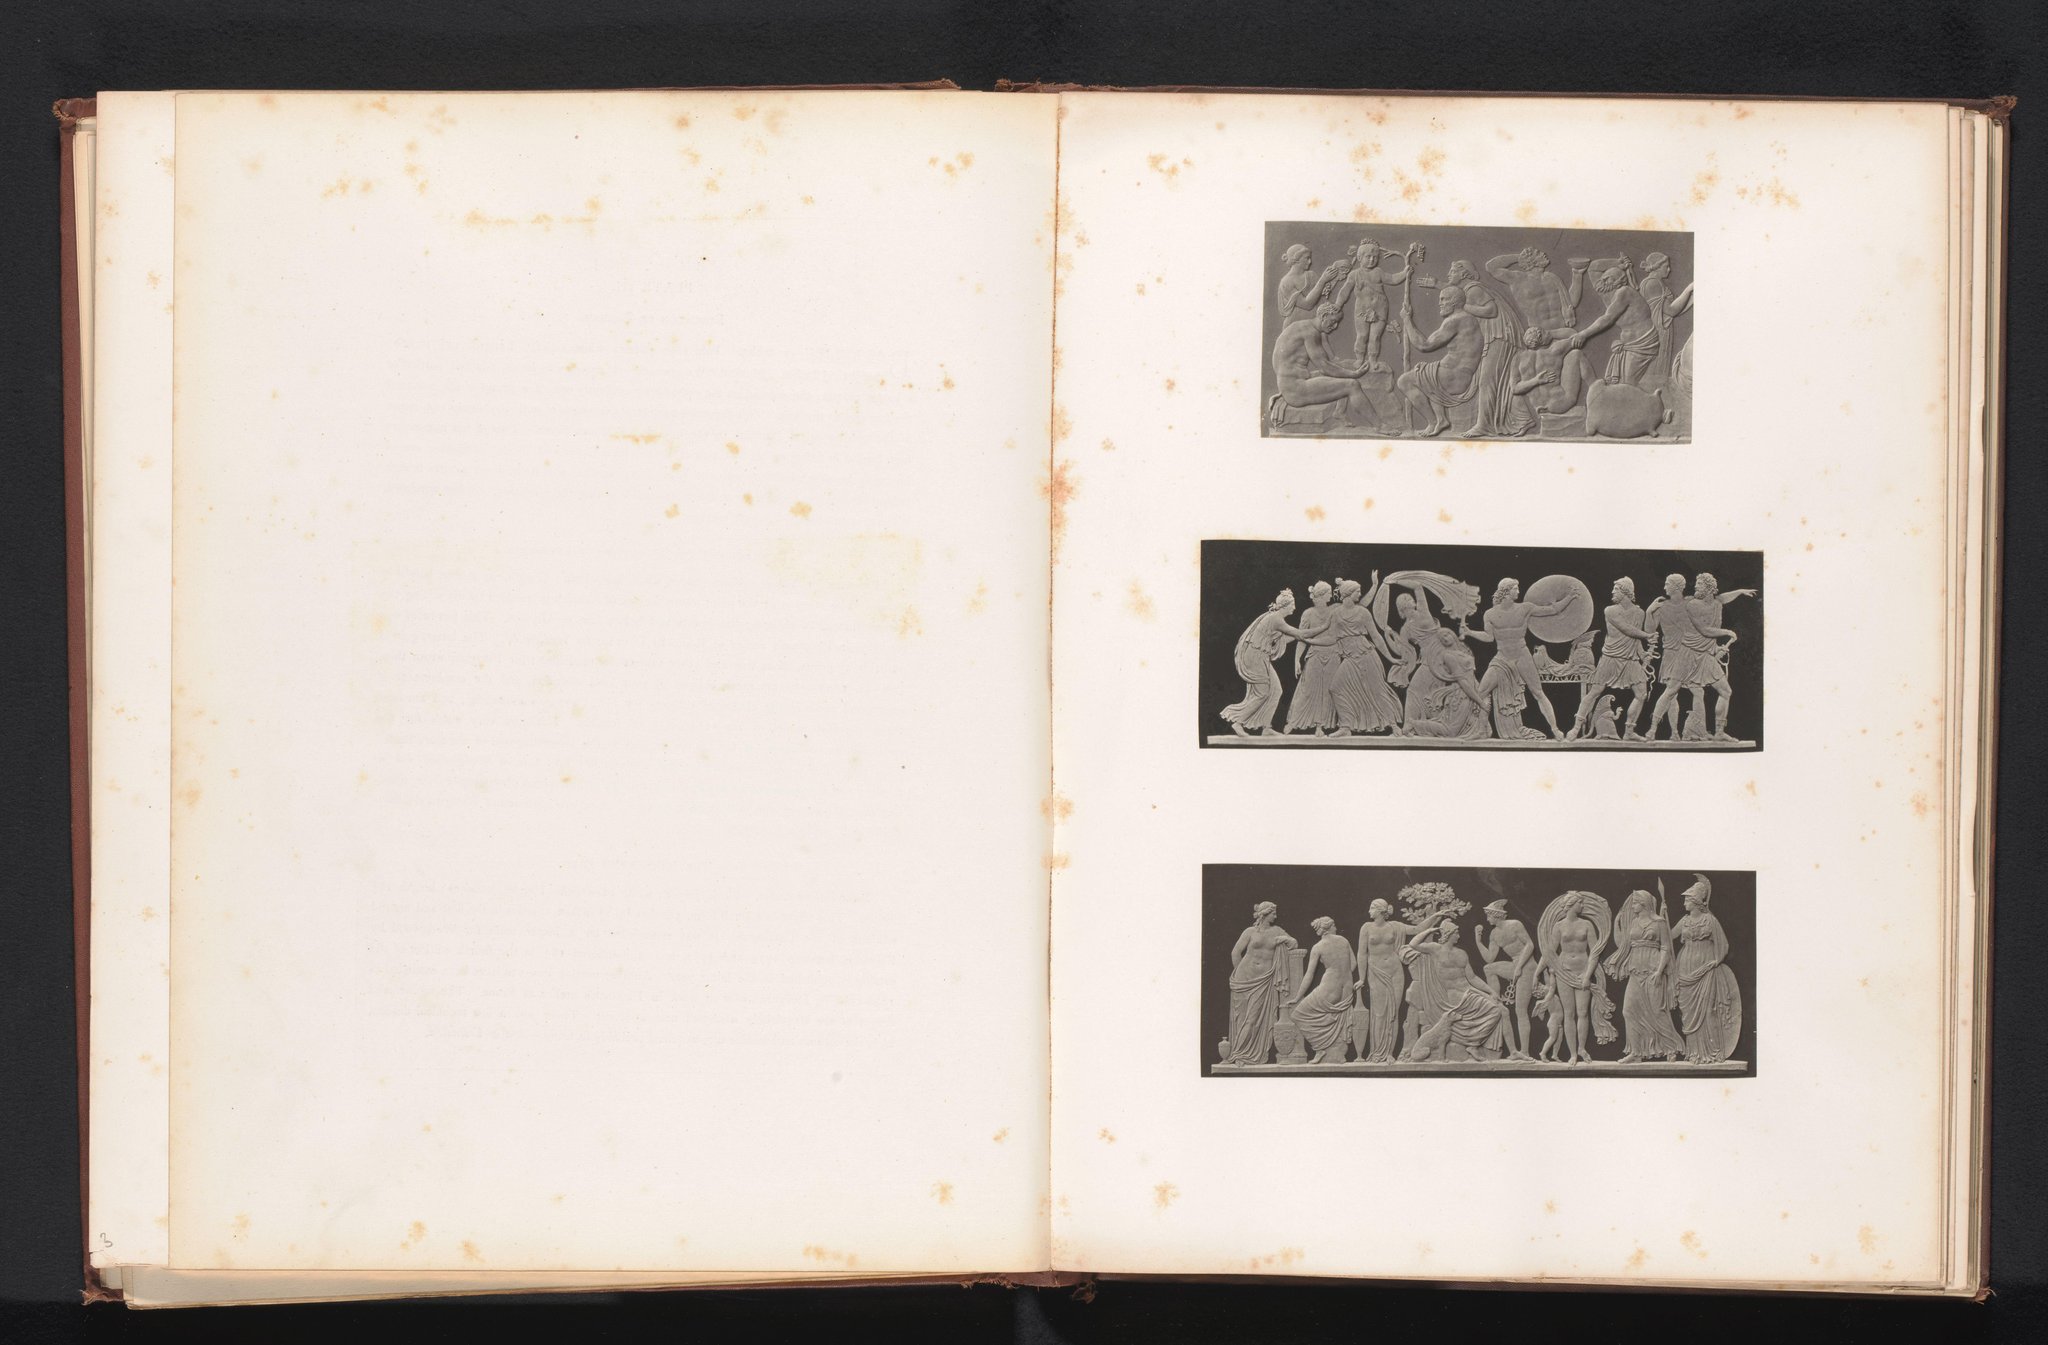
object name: photograph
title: Bas-reliëfs van Bacchus, Achilles met de dochters van Lycomedes en het oordeel van Paris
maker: joseph cundall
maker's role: fotograaf, schrijver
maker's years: 1818-1895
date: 1868-1873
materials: paper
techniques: carbon print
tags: the judgement of paris (mercury present), early life, prime youth of bacchus, (story of) achilles, sculpture (+ relief ~ sculpture)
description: Foto op zesde ongenummerde pagina na pagina 68.